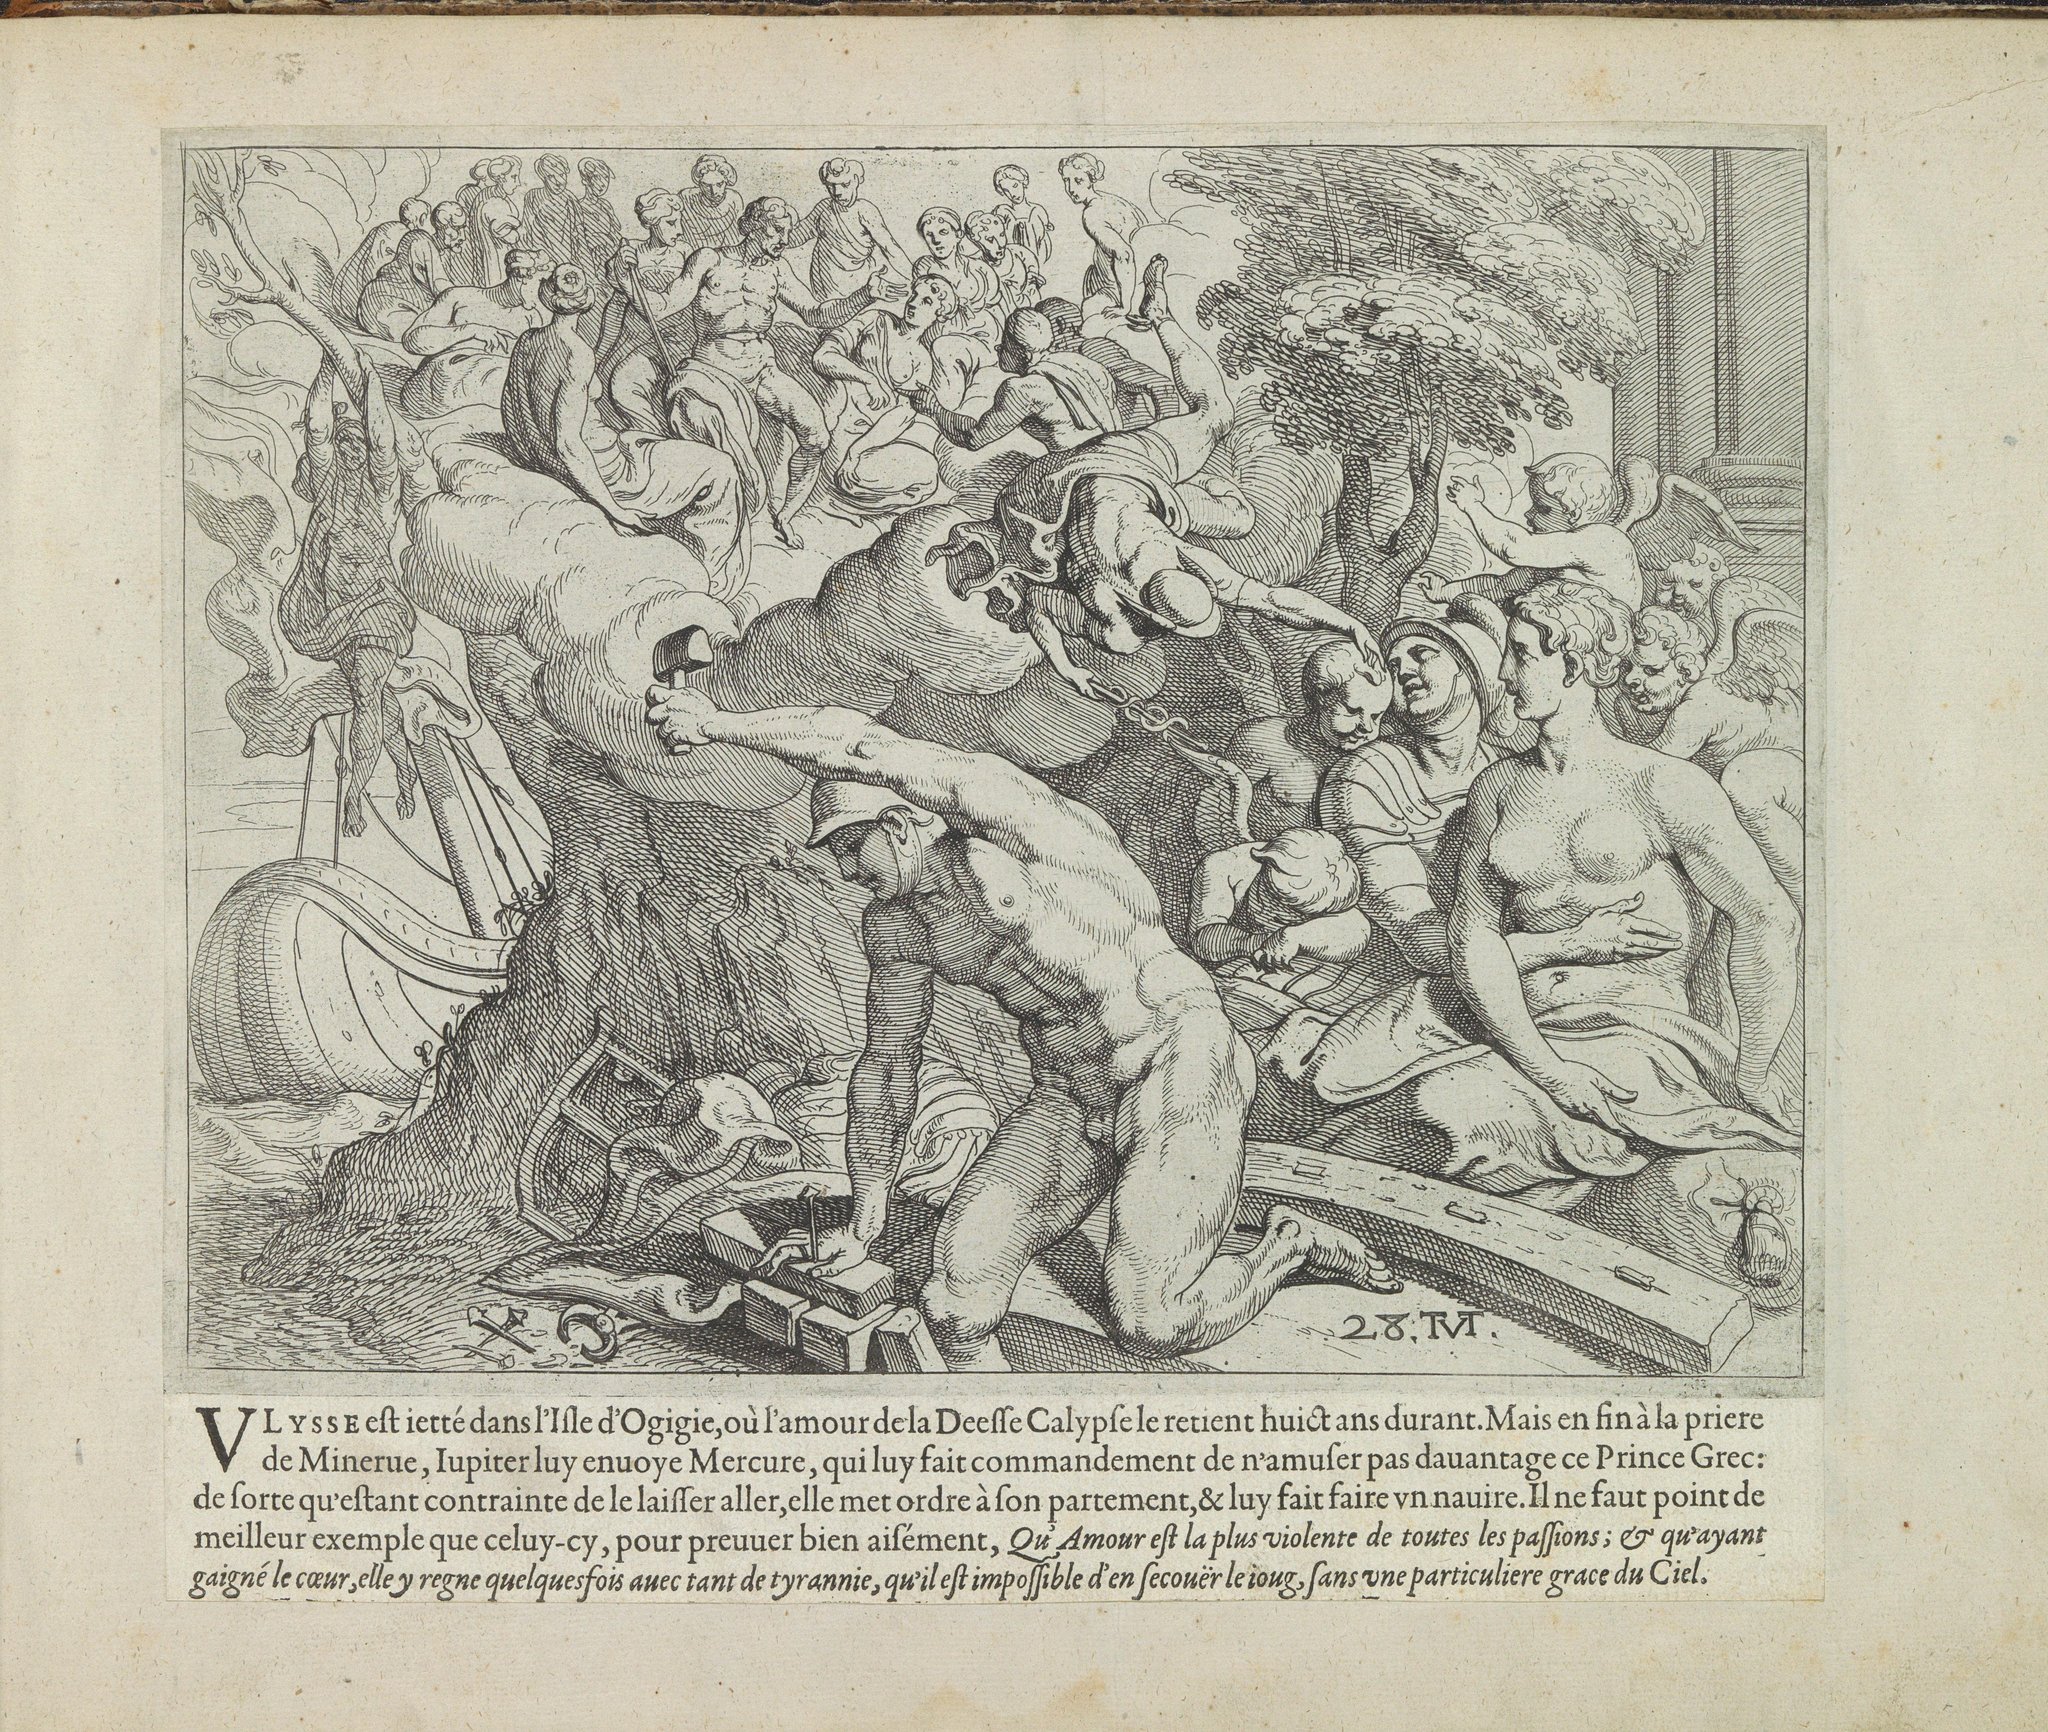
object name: album leaf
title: Les Travaux d'Ulysse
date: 1633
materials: paper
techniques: engraving, etching, letterpress printing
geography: paris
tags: mercury orders calypso to release ulysses (homer, odyssey v), ulysses escapes from charybdis by clinging to a fig-tree, ulysses builds a raft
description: Odysseus weet links op de achtergrond zichzelf te redden van het zeemonster Charybdis door zich aan een vijgenboom vast te klampen. Rechts wordt Odysseus ontvangen door Calypso. Mercurius daalt af van de Olympus om Calypso te verzoeken Odysseus te laten gaan. Op de voorgrond bouwt Odysseus een vlot. De prent maakt deel uit van een album.